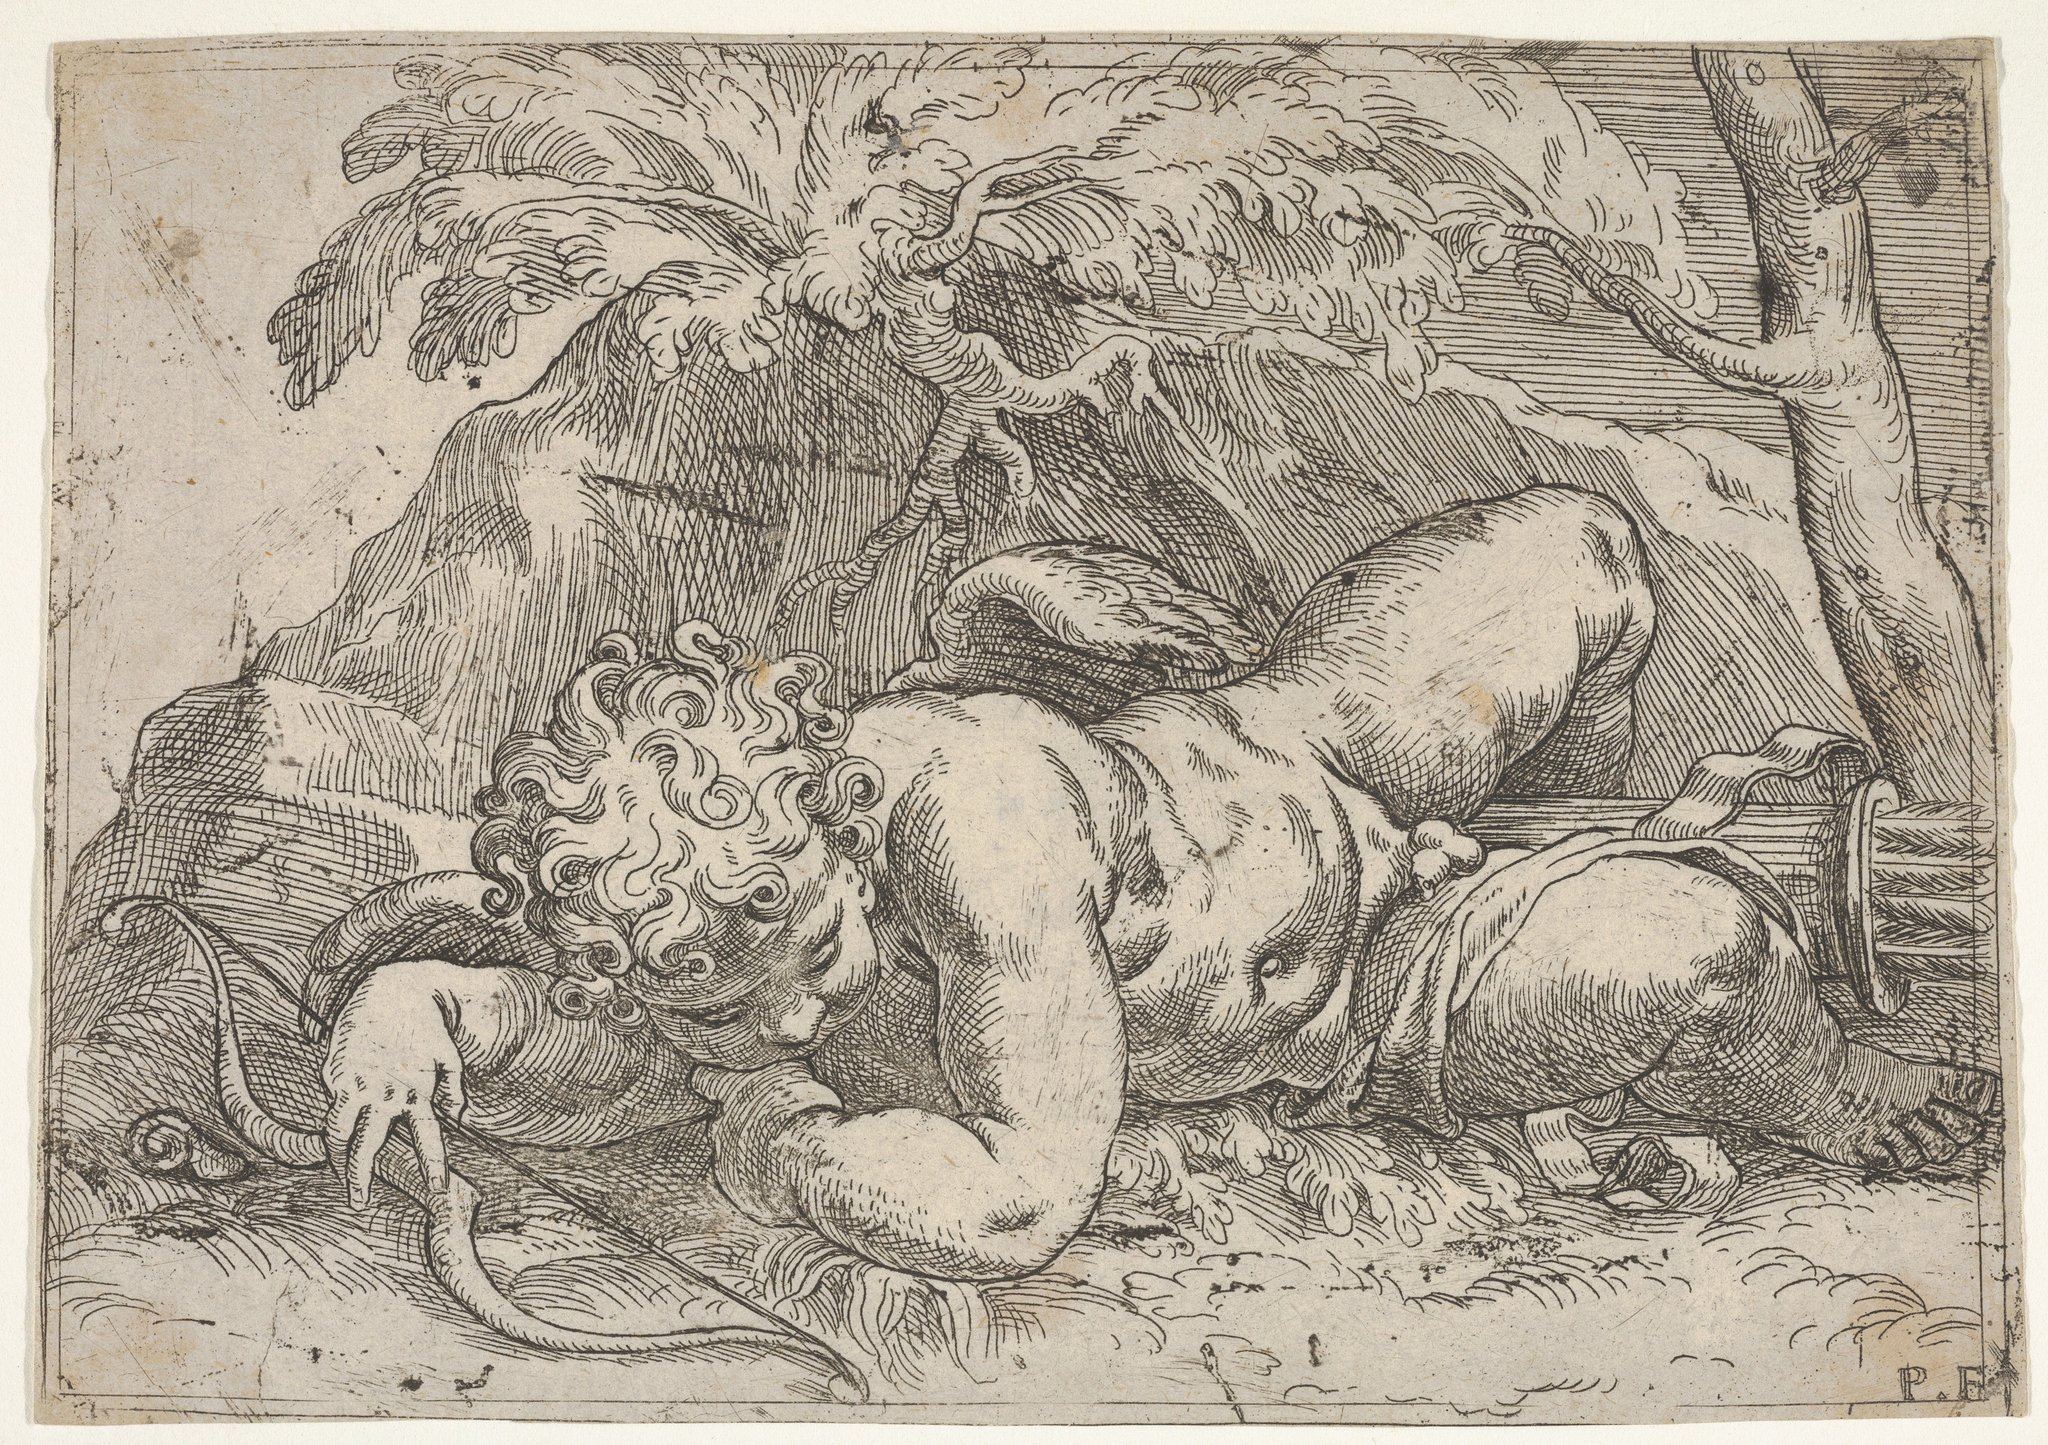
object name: print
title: Sleeping Cupid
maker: paolo farinati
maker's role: artist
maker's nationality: italian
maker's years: 1524-1606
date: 1560-1606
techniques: etching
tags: bow and arrow,sleeping,cupid